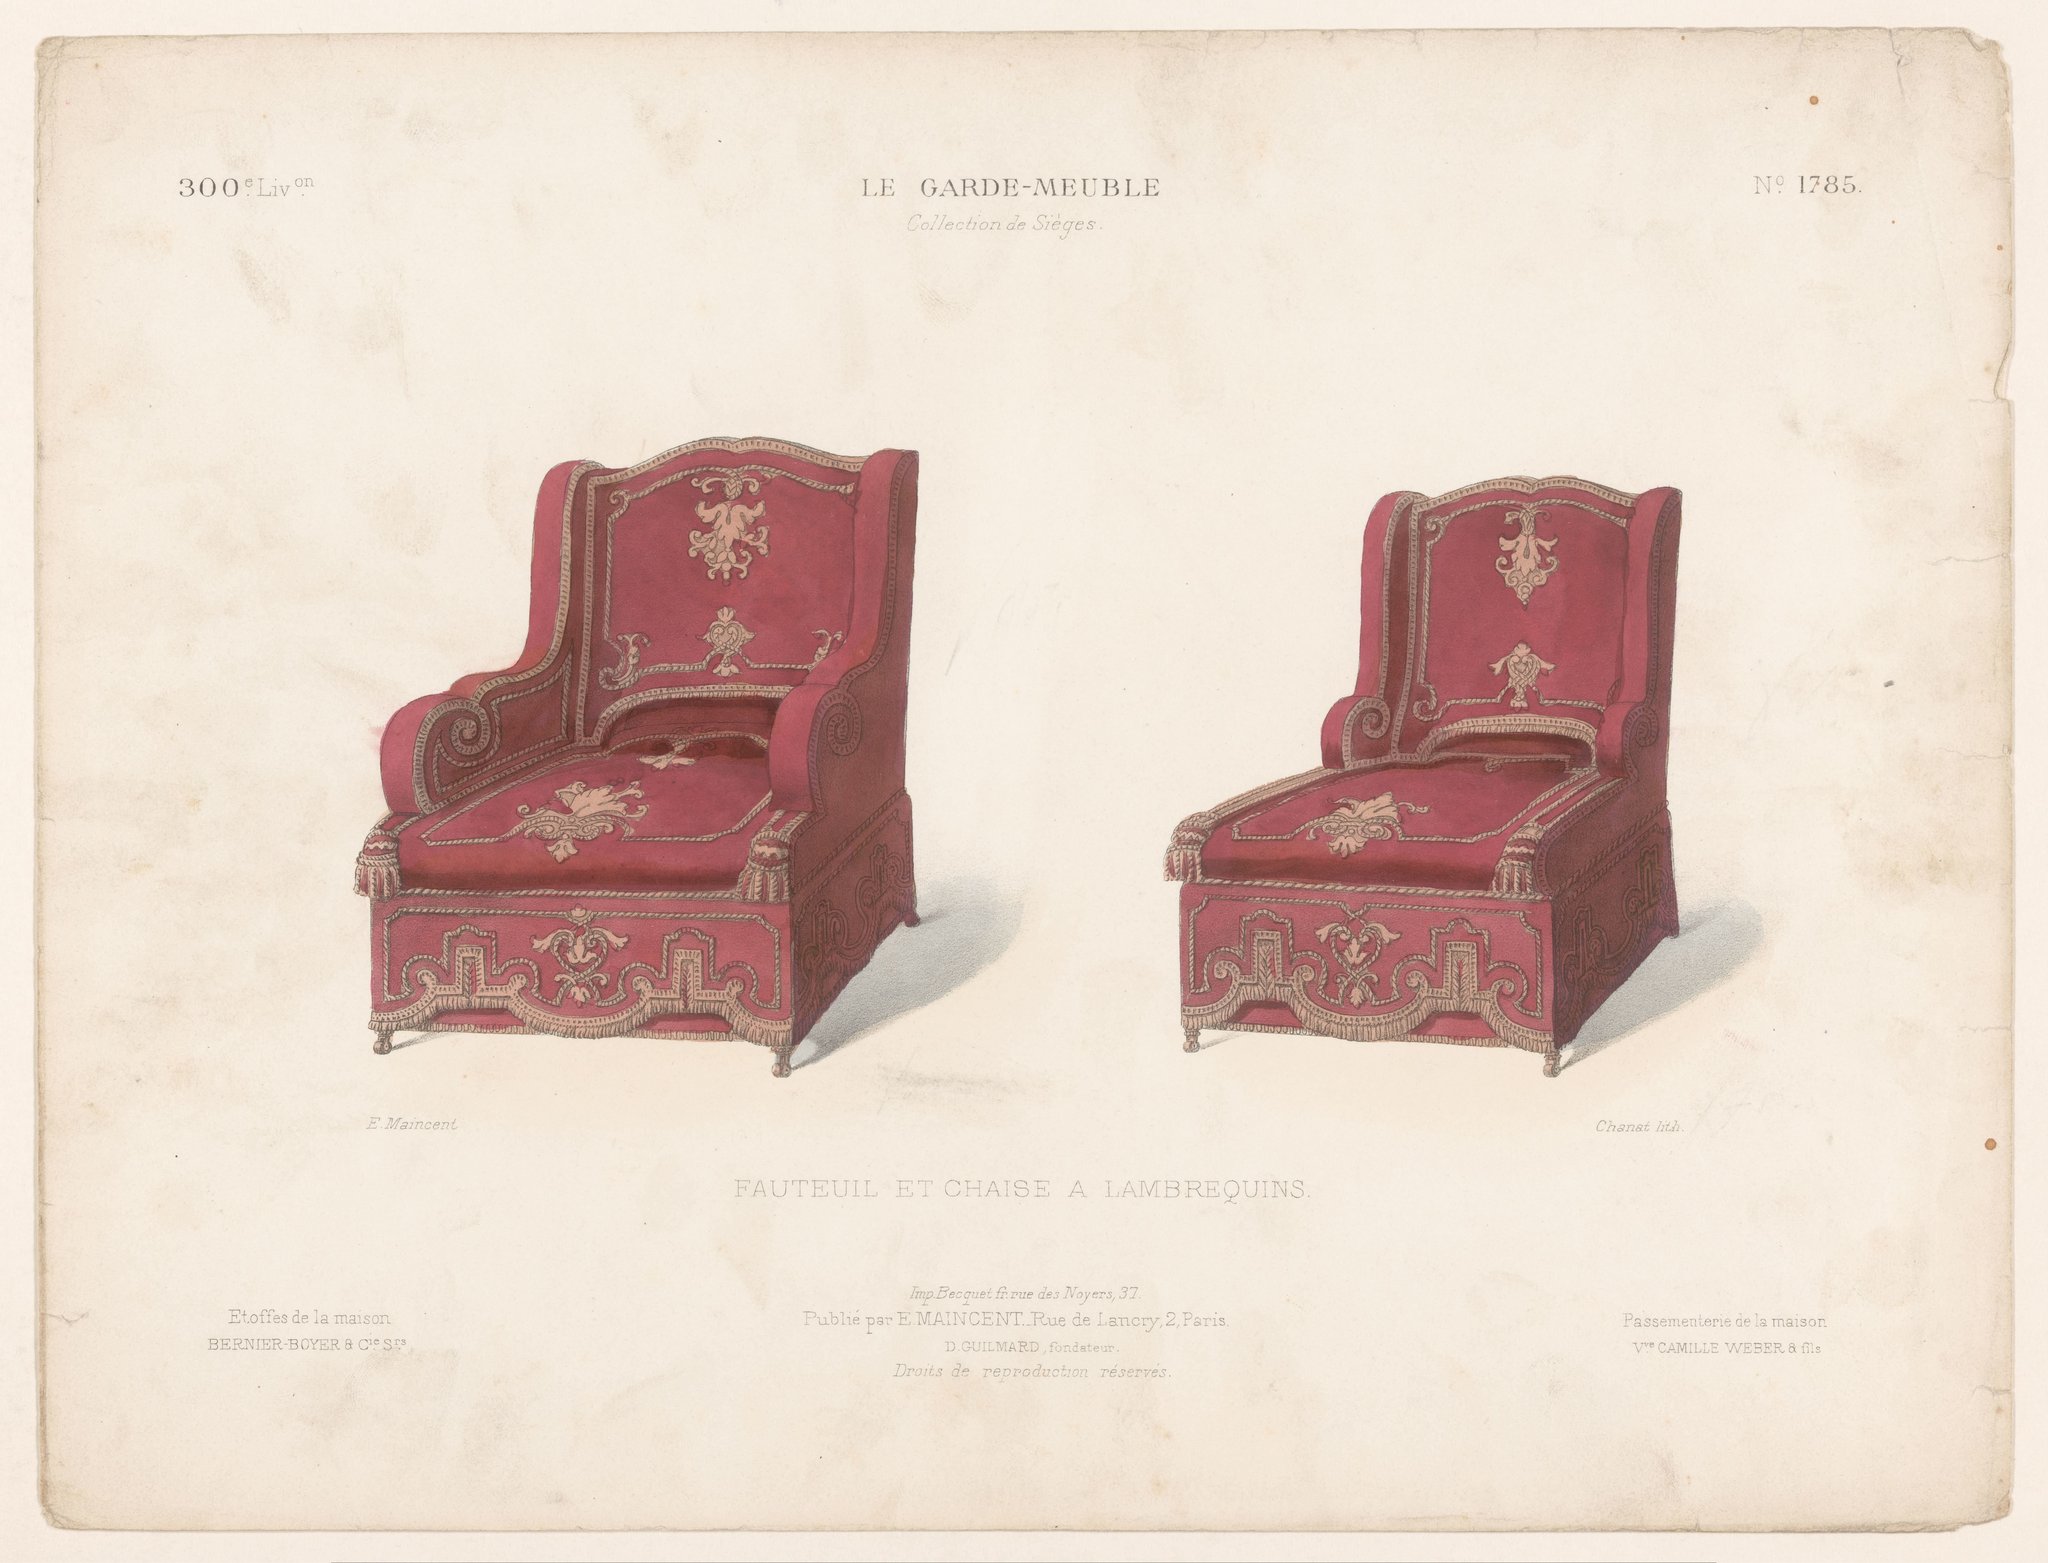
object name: print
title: Fauteuil et chaise a lambrequins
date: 1885-1895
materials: paper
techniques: hand coloring, lithograph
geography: paris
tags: seating furniture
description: Ieder Livraison in de serie Le Garde-Meuble bevat negen platen: drie 'sièges' (zitmeubels), drie 'meubles' (diverse meubels zoals tafels en kasten) en drie 'tentures' (gordijnen en draperieën).